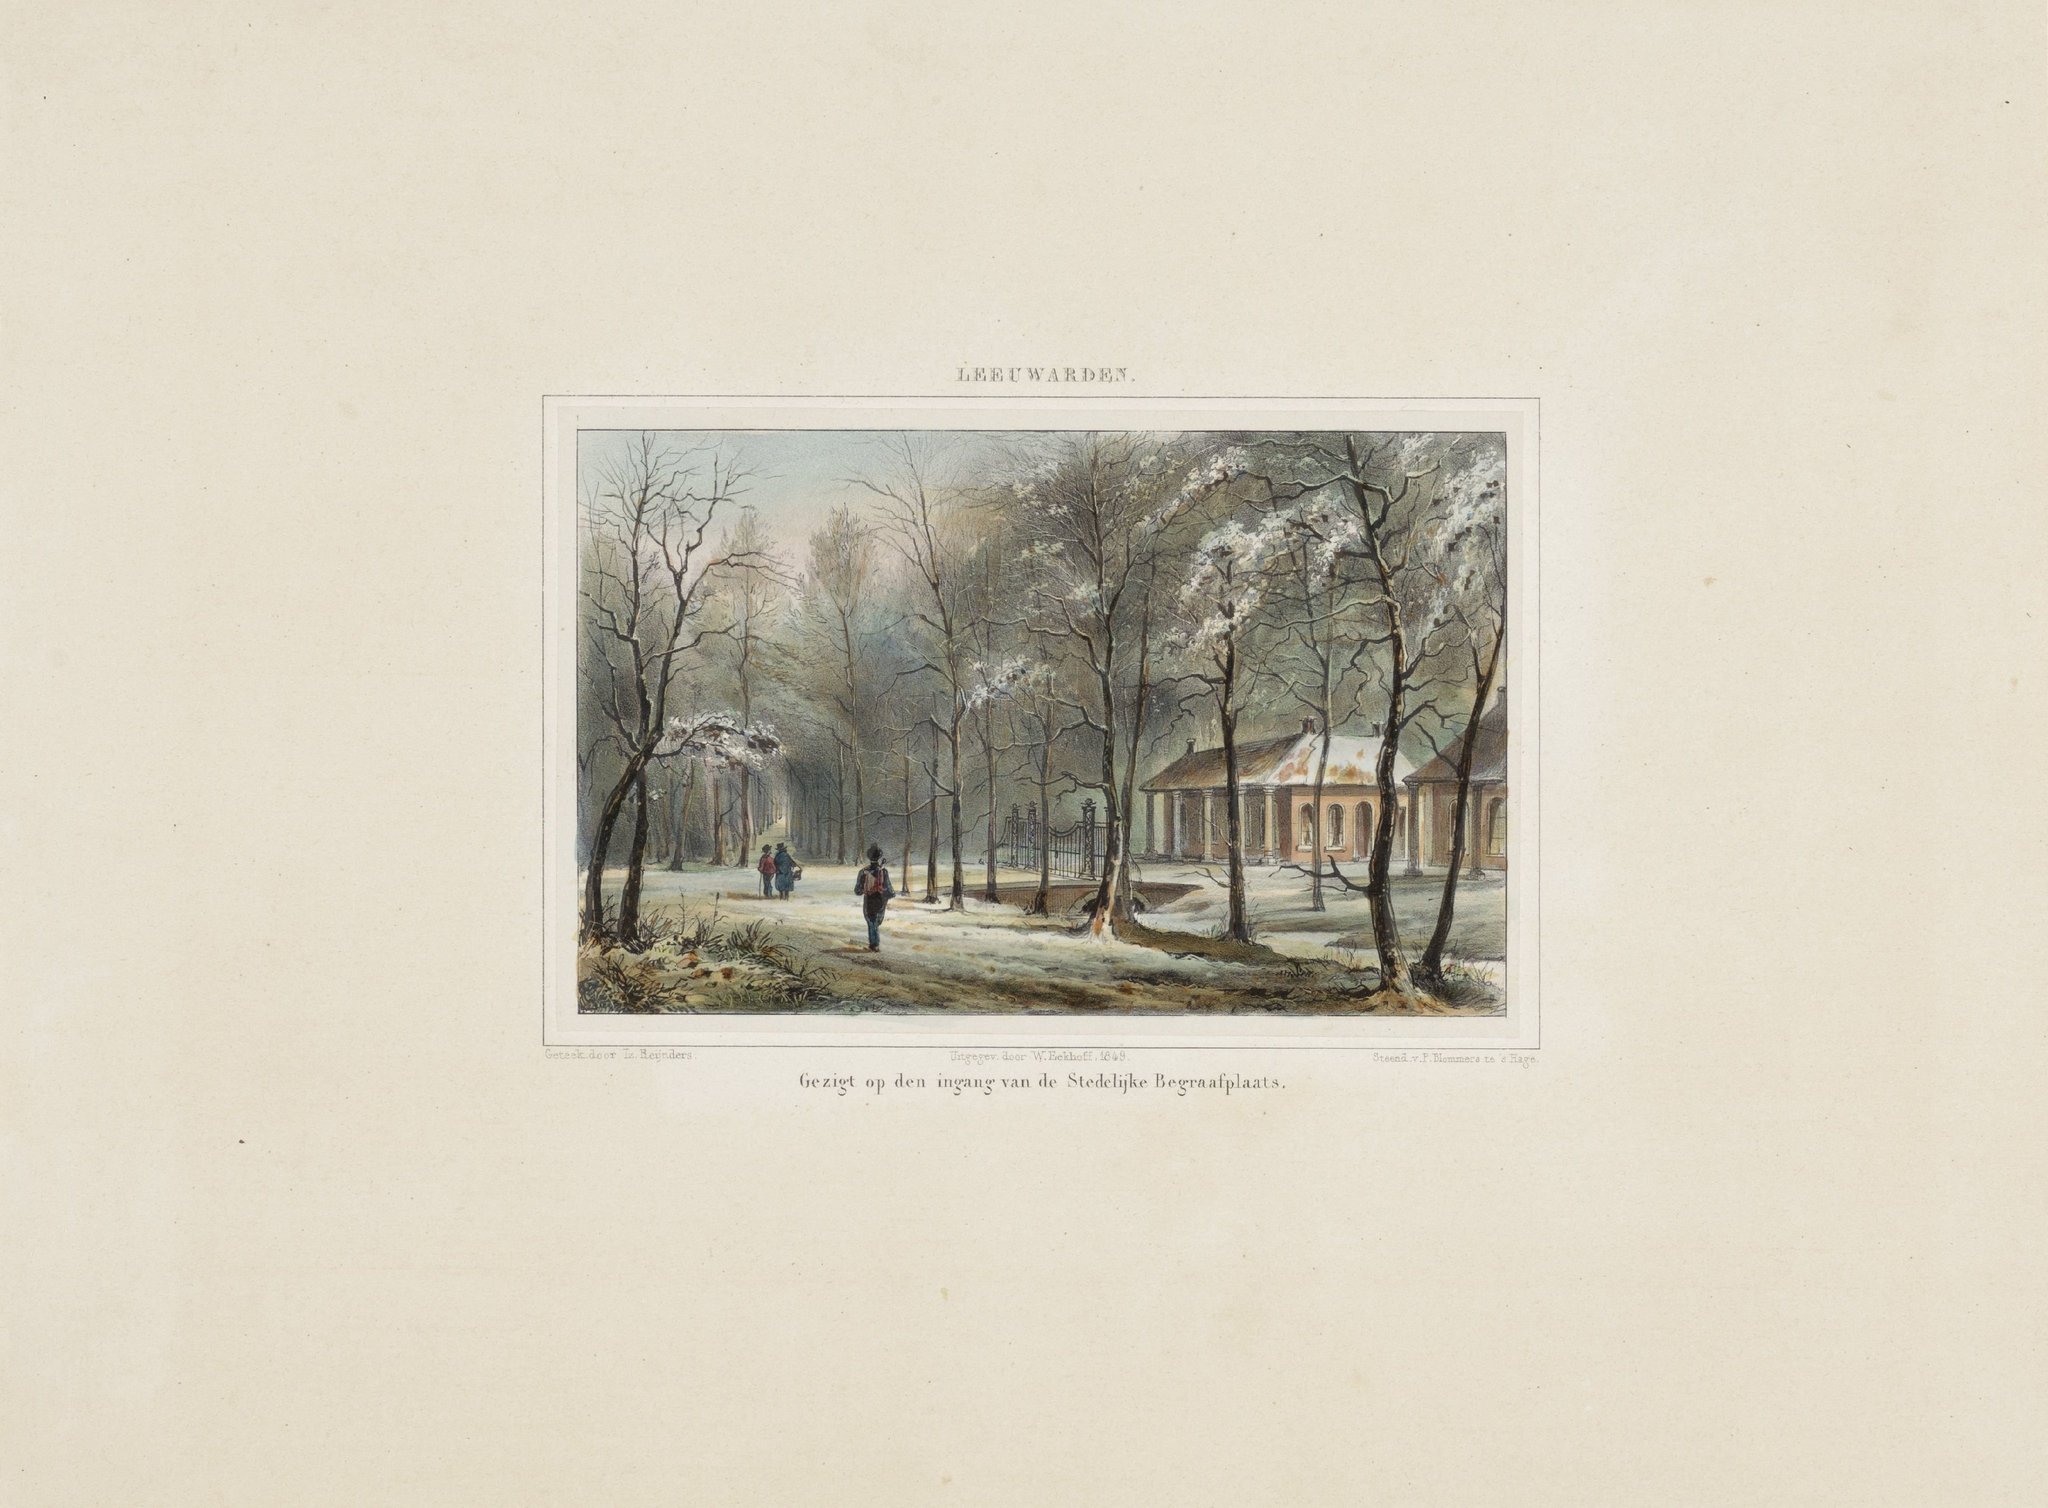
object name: print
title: Gezigt op den ingang van de Stedelijke Begraafplaats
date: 1849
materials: paper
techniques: hand coloring, lithograph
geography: leeuwarden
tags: winter landscape; landscape symbolizing winter (the four seasons of the year), cemetery, park-like burying ground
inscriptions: collector's mark: Lugt 2228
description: Rechts van een bospad, in een besneeuwd landschap, ligt de ingang tot de begraafplaats. Op het pad lopen enkele figuren.